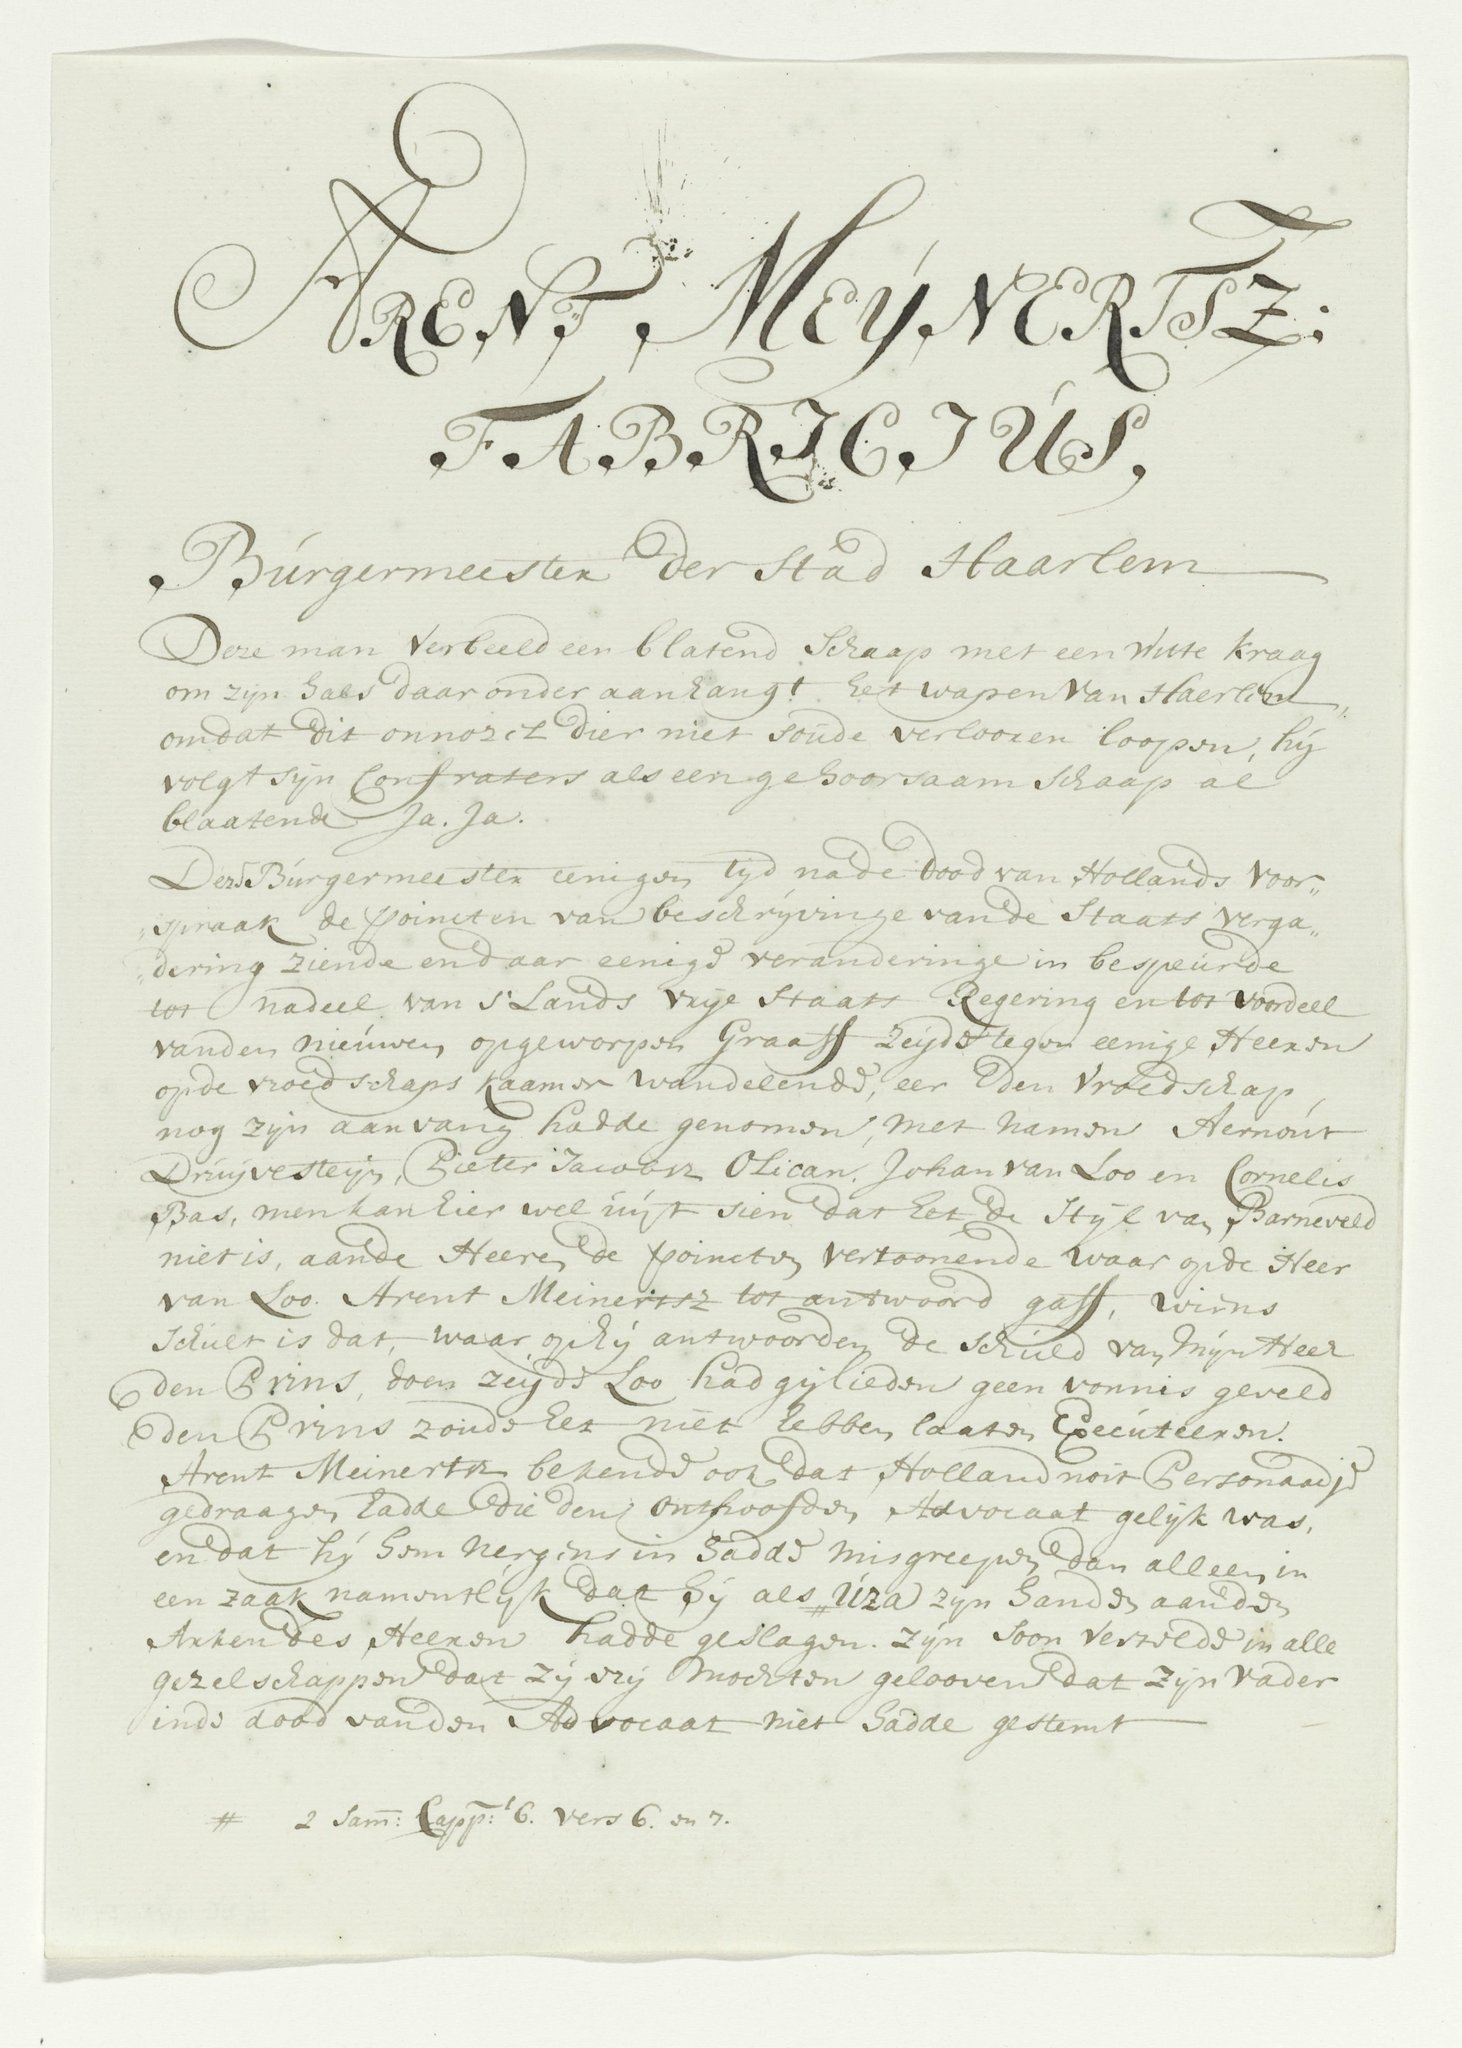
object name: poem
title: Spotvers bij het portret van Arent Meinertsz. Fabricius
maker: Anonymous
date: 1710-1720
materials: paper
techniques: pen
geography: netherlands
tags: the hague, johan van oldenbarnevelt, mayor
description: Spotprent van Arent Meinertsz. Fabricius, rechter van Van Oldenbarnevelt; wit schaap met blauwe bonthoed en schort waarop wapen, in krans van bloemen en bladeren. Daaronder cartouche met aan weerszijden twee zeemeerminnen. In cartouche naam en daarboven nr. 9. Behorende bij serie aquarellen in boek.